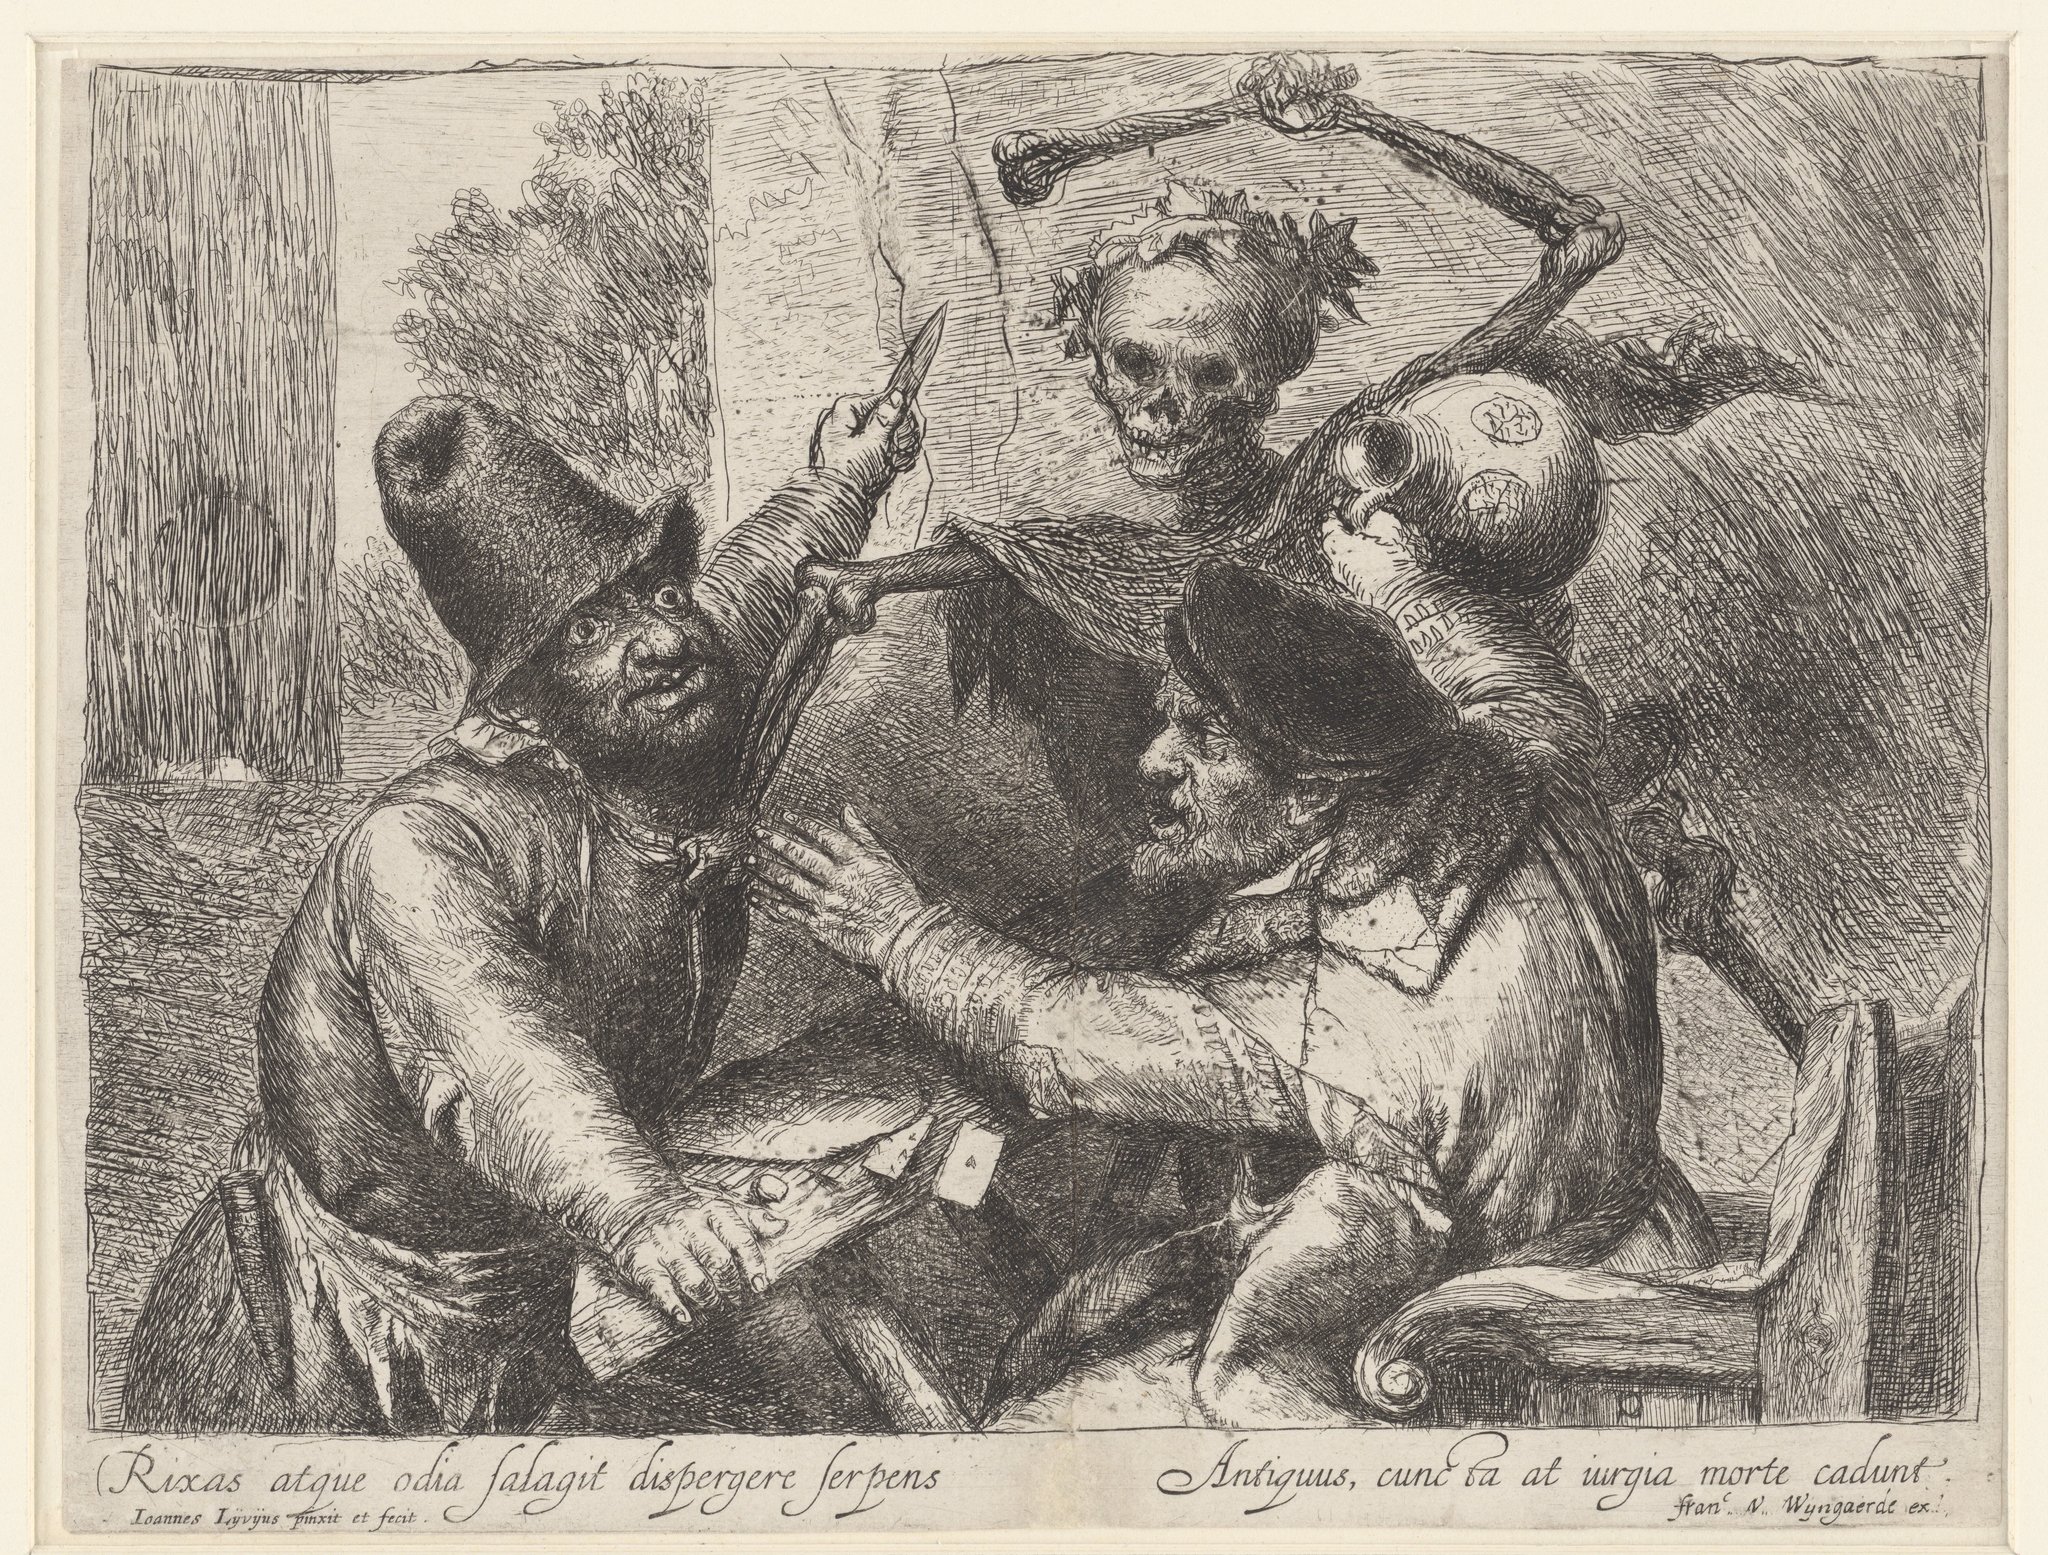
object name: print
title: Twistende kaartspelers en de Dood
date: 1638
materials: paper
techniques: etching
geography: antwerp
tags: (personifications of) 'vanitas', the vanity of human life; fragilità humana, fugacità delle grandezze & della gloria mondana, meditatione della morte, opera vana, piacere vano, vana gloria, vanità (ripa), card games, fighting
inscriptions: collector's mark: Lugt 240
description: Twee kaartspelers zijn slaags geraakt, de oude man rechts zwaait met een kruik als wapen en zijn tegenspeler heeft de tafel met speelkaarten omgestoten terwijl een hand met een mes dreigend in de lucht steekt. De Dood komt tussenbeide door de man links bij de keel te grijpen en te zwaaien met een bot. Onder de prent staat een Latijns motto in twee regels dat zinspeelt op de ijdelheid (ledigheid) van de mens op het moment dat de dood in zicht is.